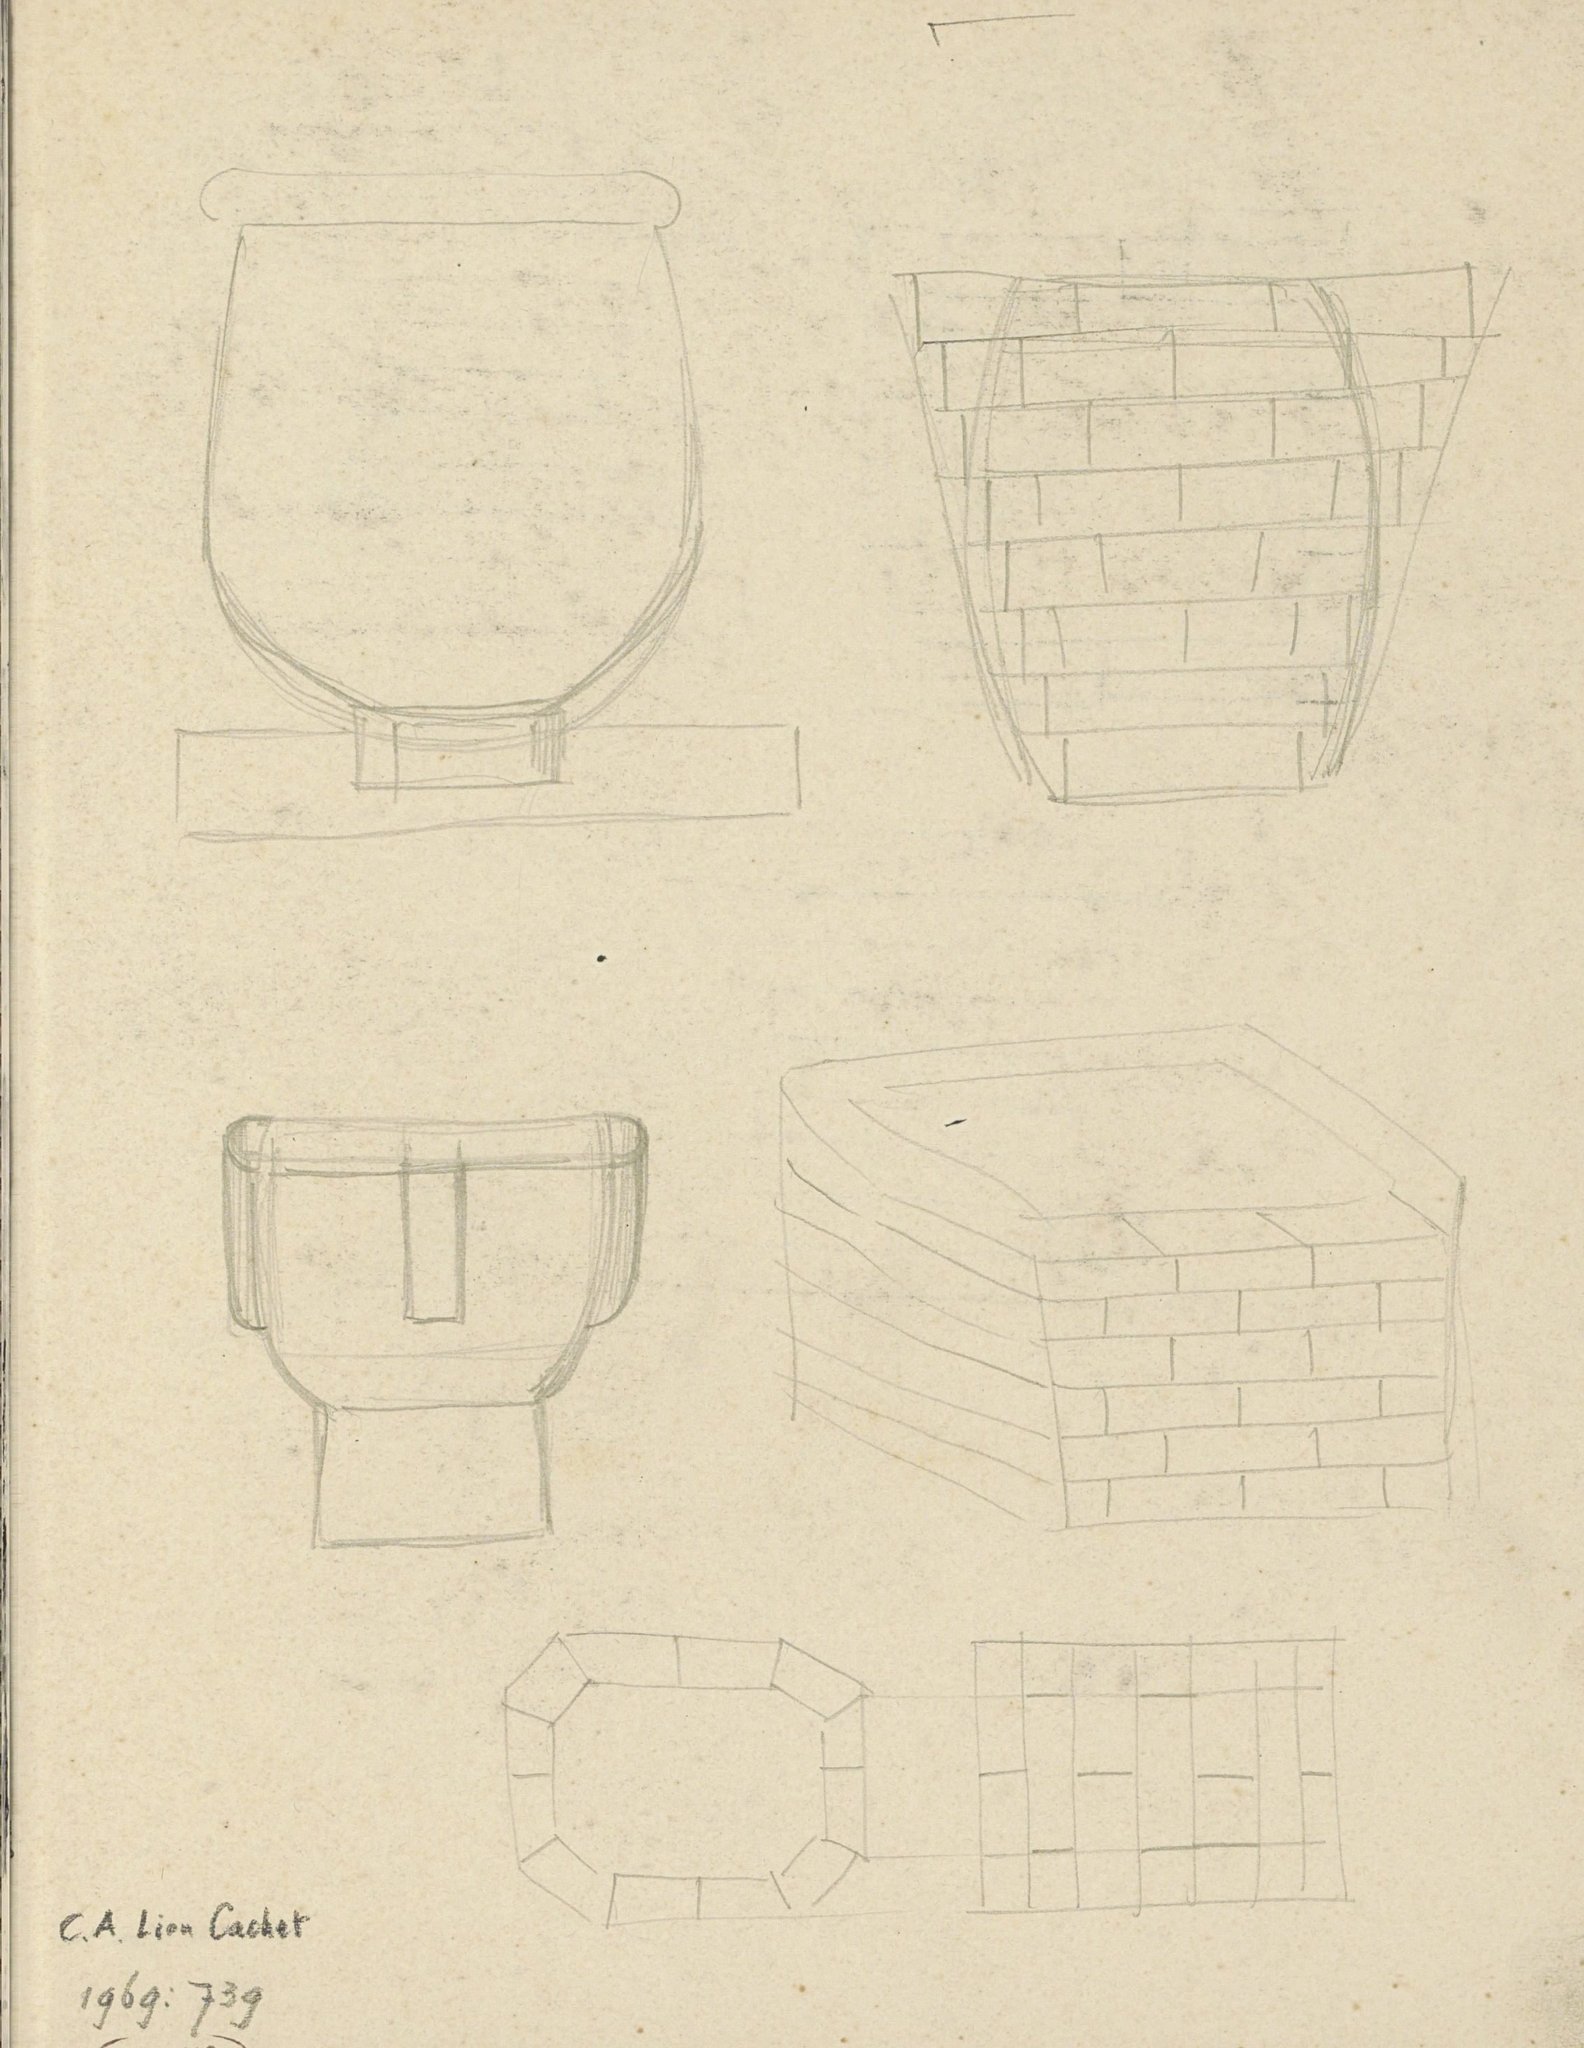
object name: sketchbook leaf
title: Ontwerpen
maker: carel adolph lion cachet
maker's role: draughtsman, print maker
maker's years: 1864-1945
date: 1930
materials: paper, pencil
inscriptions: collector's mark: Lugt 2228a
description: Blad 1 recto uit een schetsboek met 9 bladen.